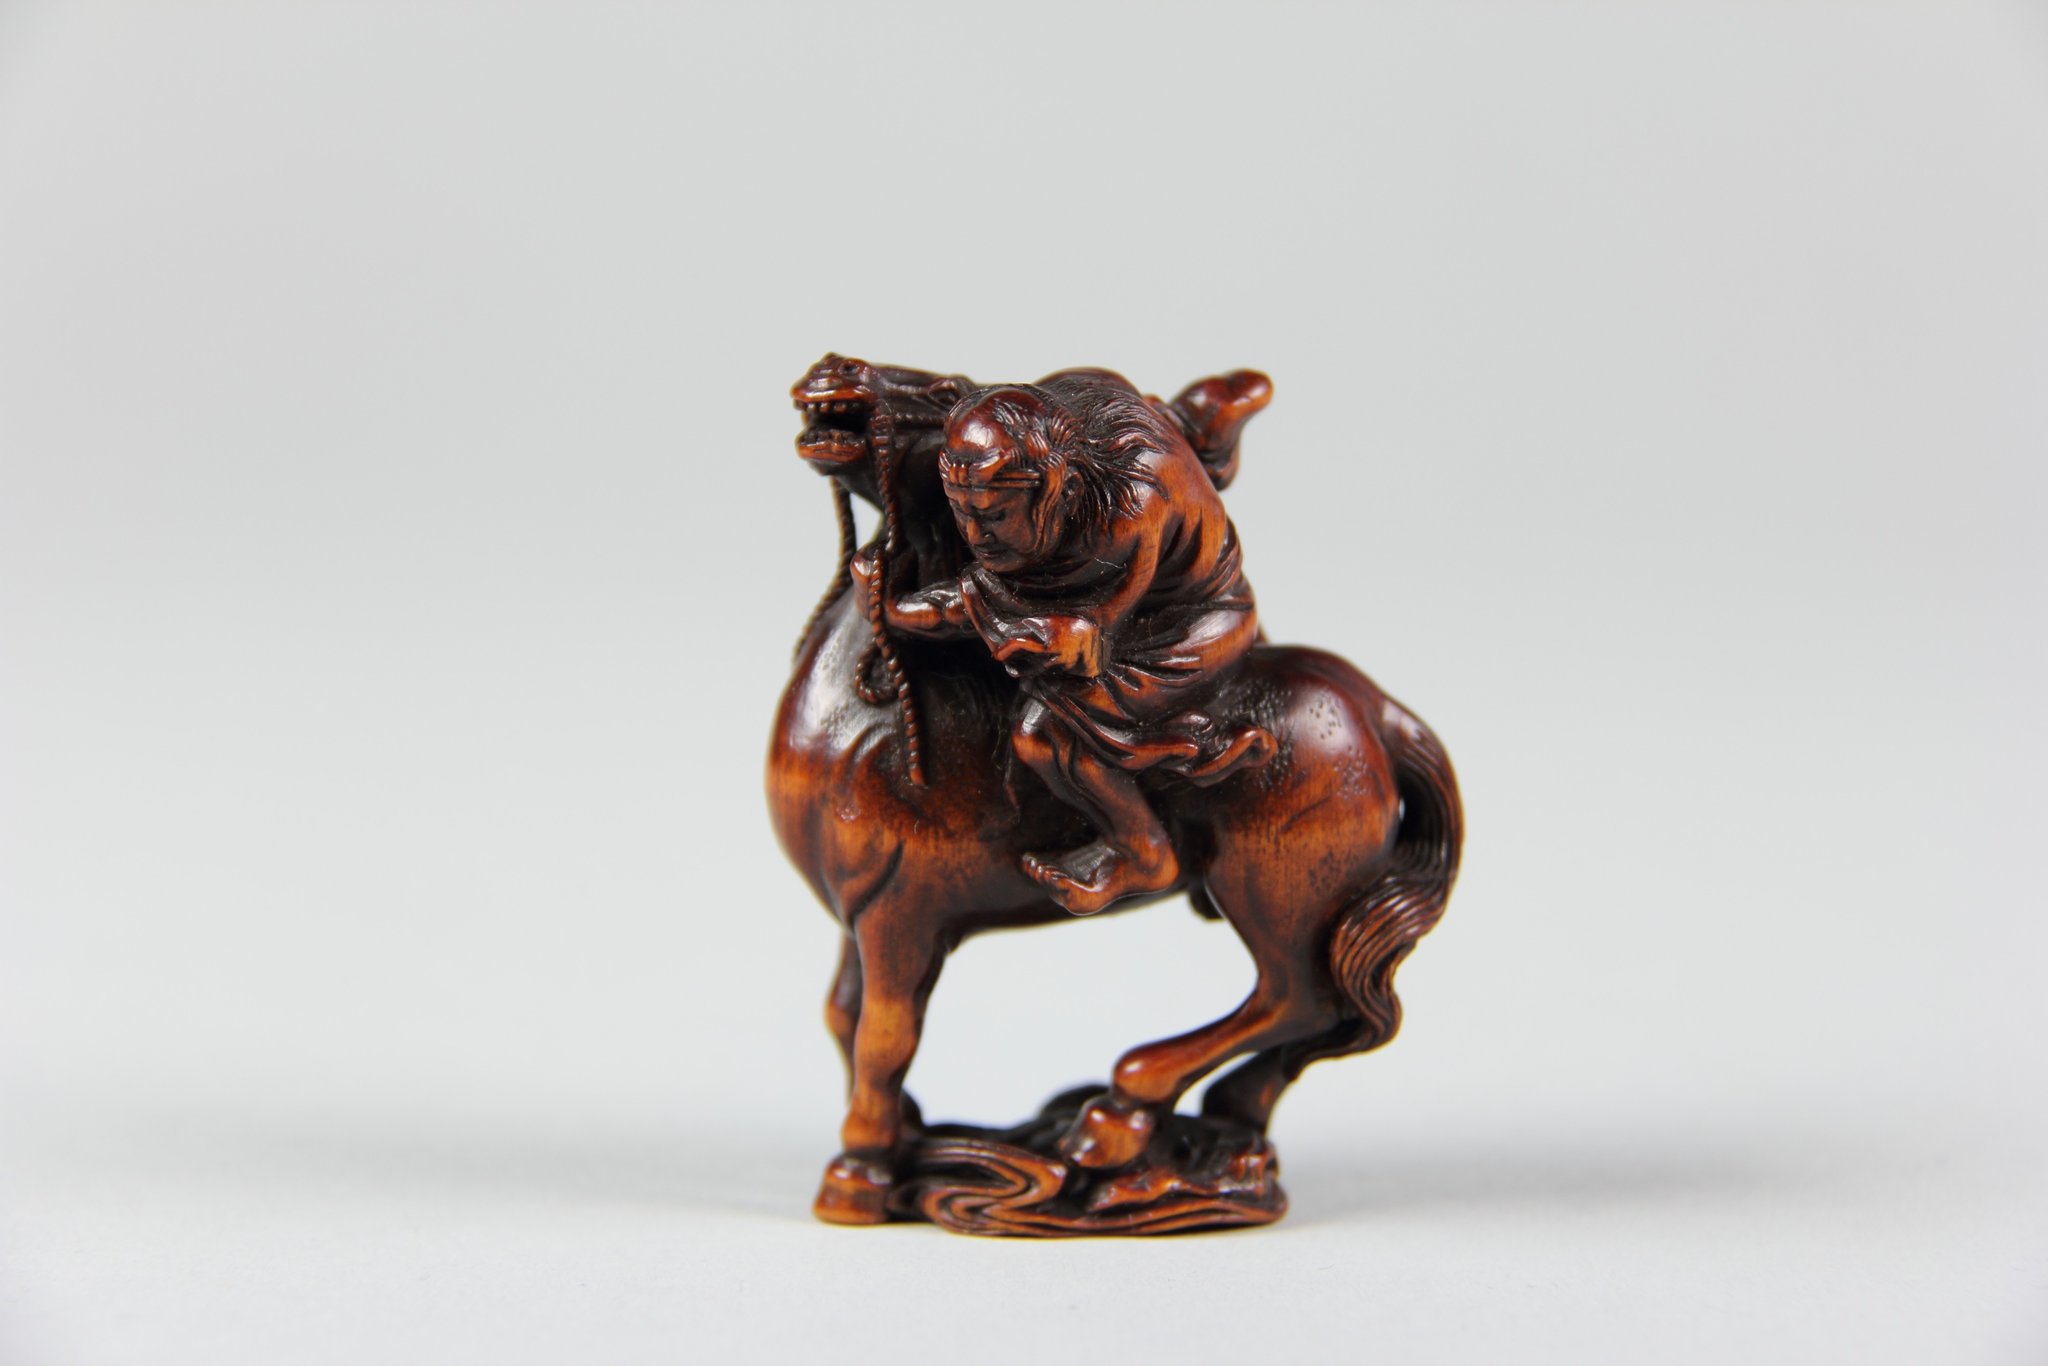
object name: netsuke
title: Netsuke of Equestrian Figure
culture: japanese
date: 1701-1800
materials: wood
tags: men,horses